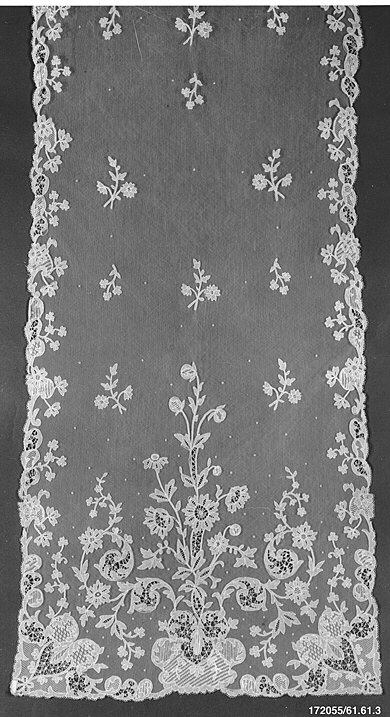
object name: scarf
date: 1801-1900